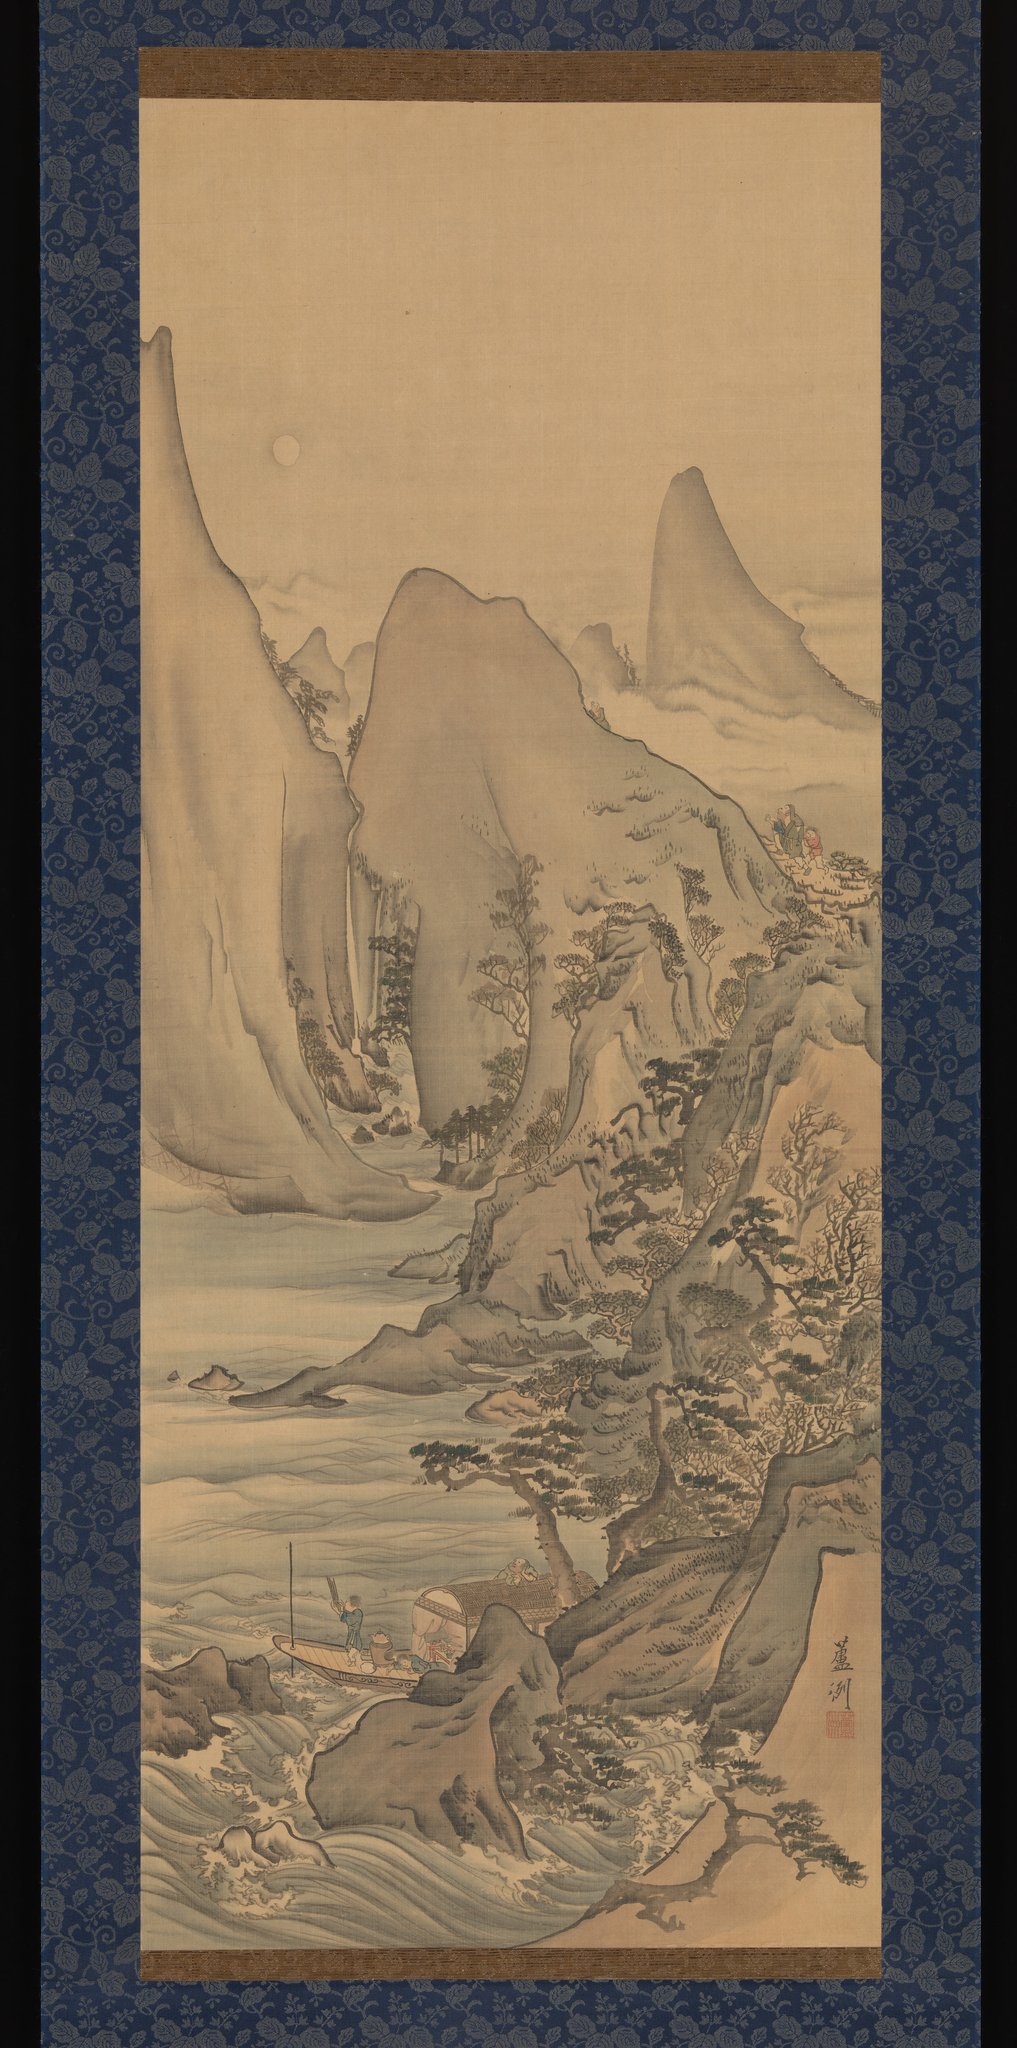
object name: hanging scroll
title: Boat under the Moon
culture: japanese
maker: nagasawa roshū 長澤蘆洲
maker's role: artist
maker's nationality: japanese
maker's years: 1767-1847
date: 1801-1833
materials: ink, silk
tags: mountains,landscapes,boats